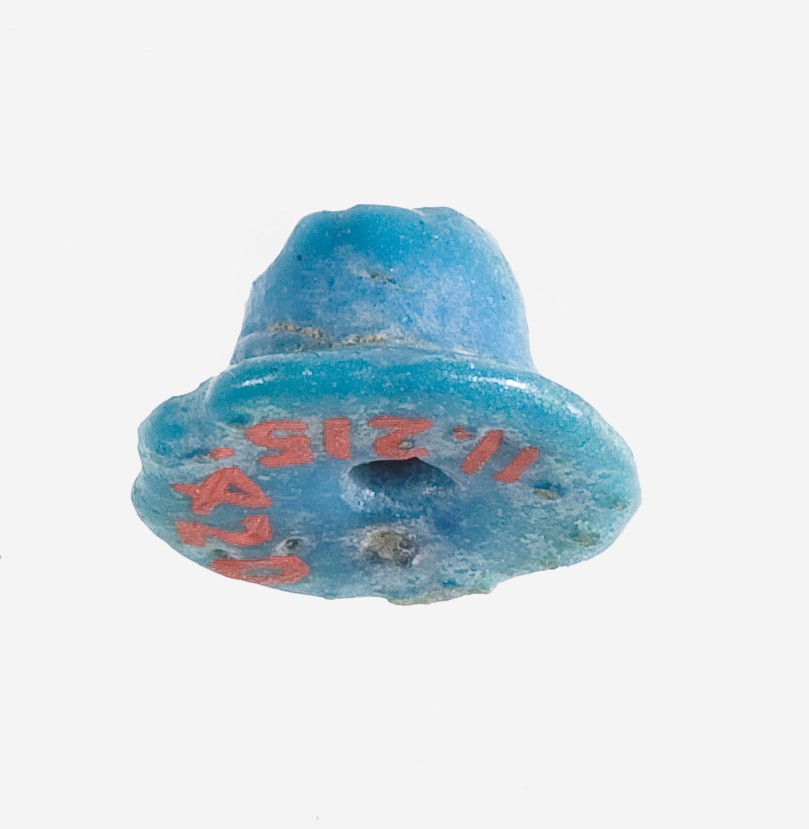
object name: pendant, umbel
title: Umbel Pendant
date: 1390-1352 BCE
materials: faience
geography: egypt